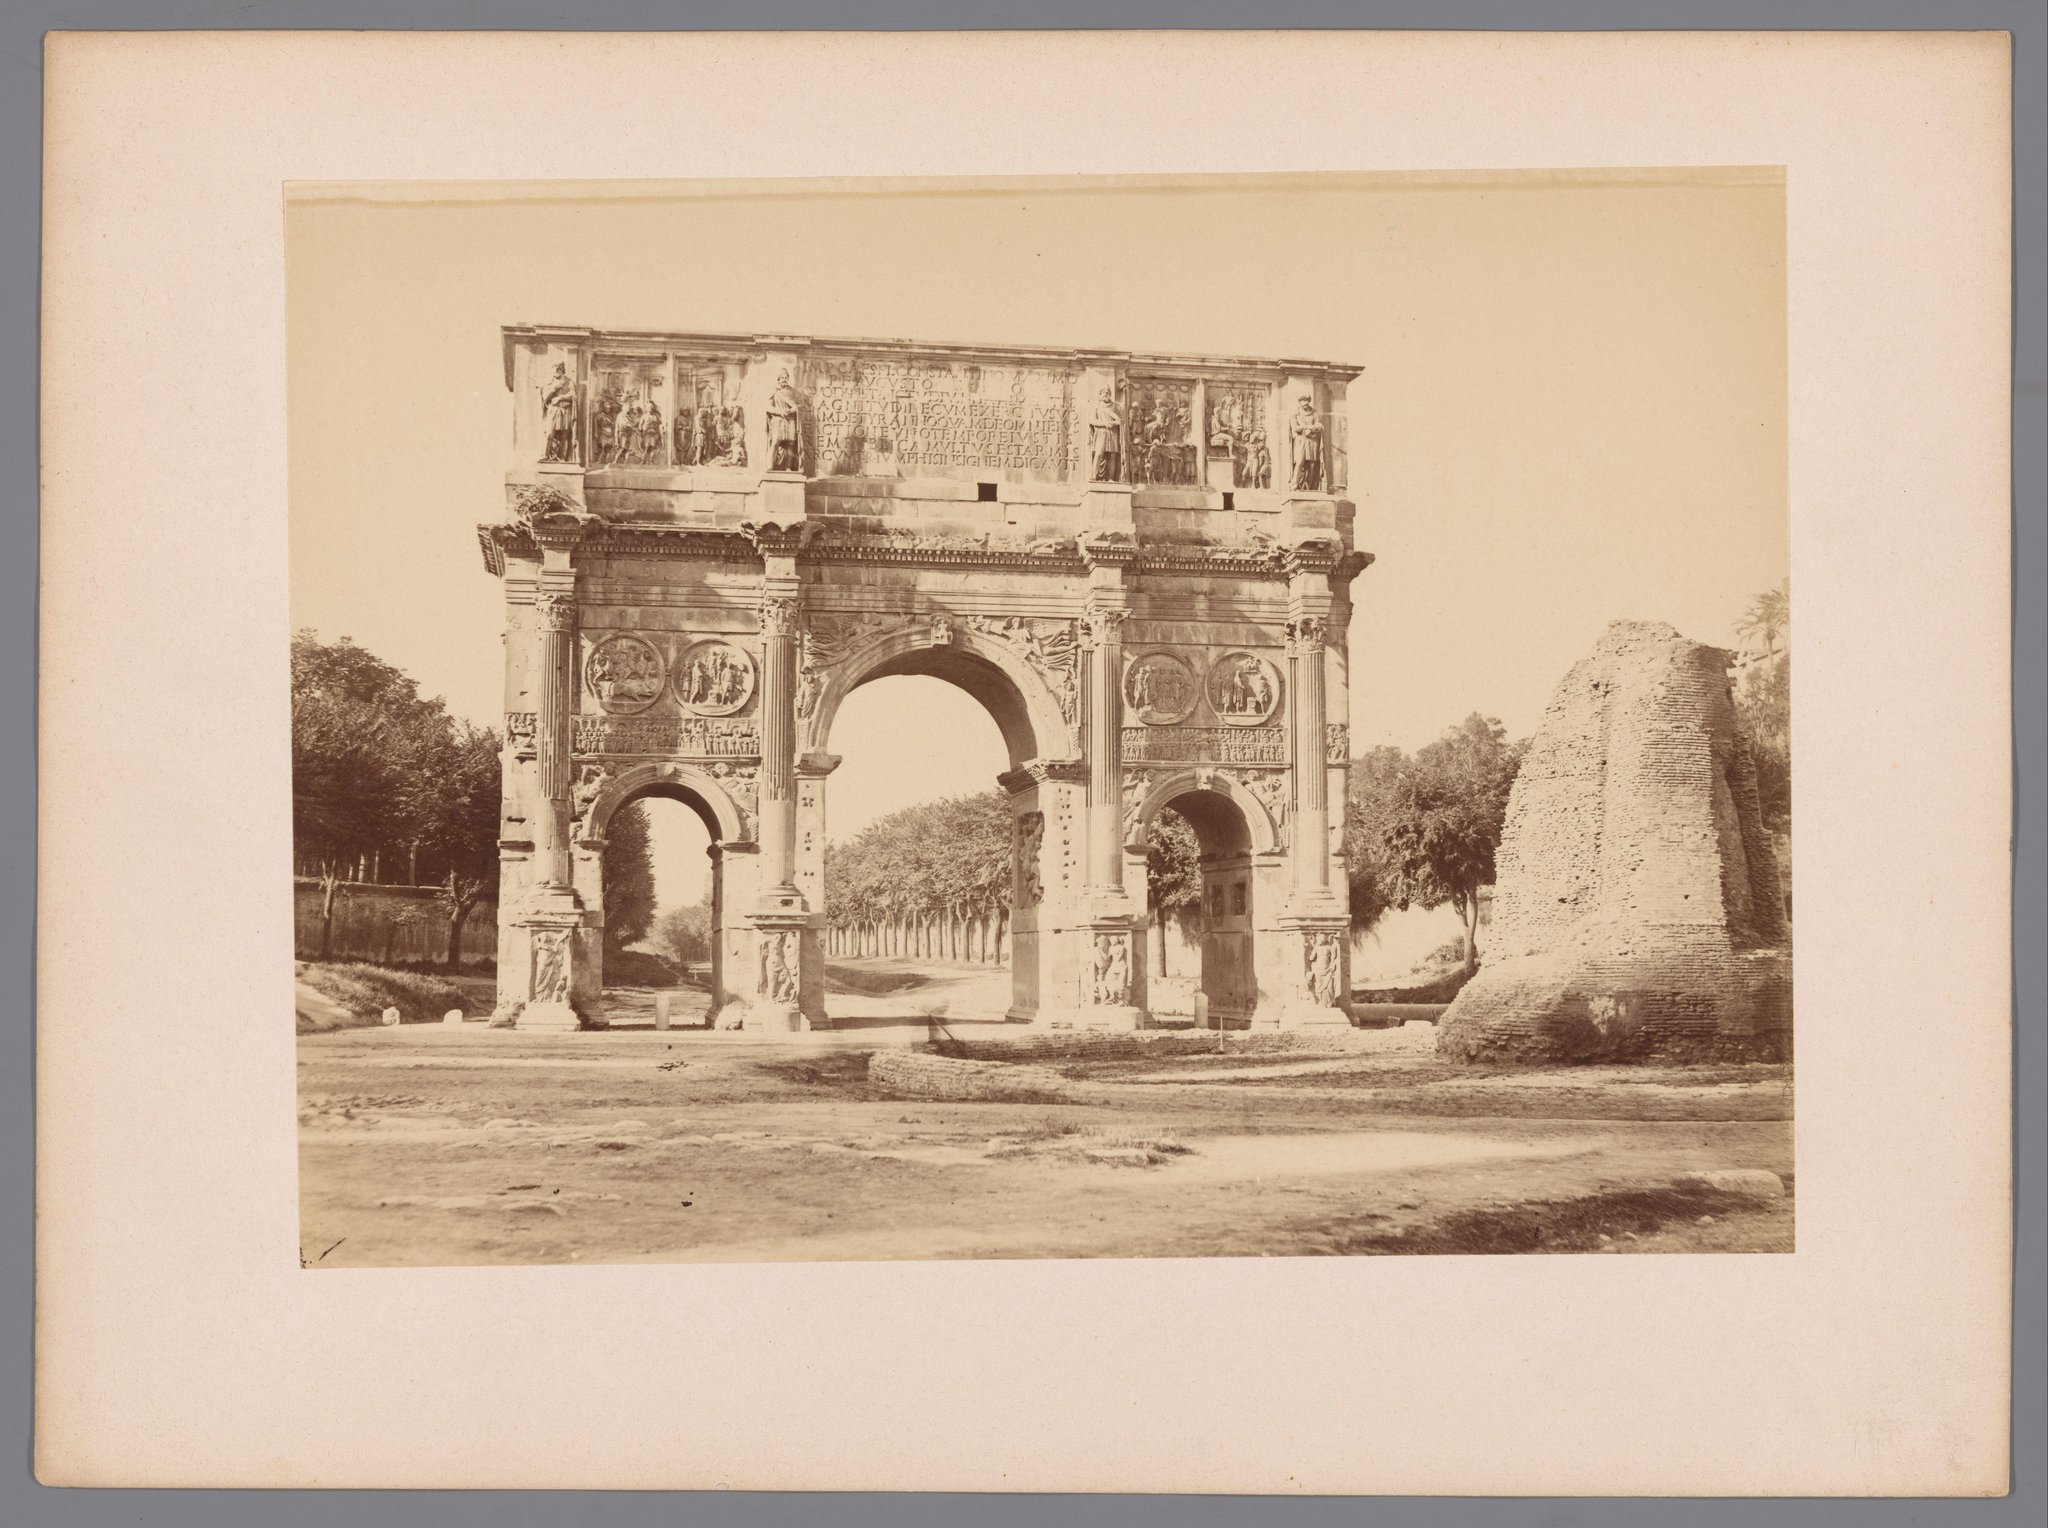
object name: photograph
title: Boog van Constantijn te Rome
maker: Anonymous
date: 1851-1900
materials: cardboard, paper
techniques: albumen print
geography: rome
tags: triumphal arch, arch of constantine